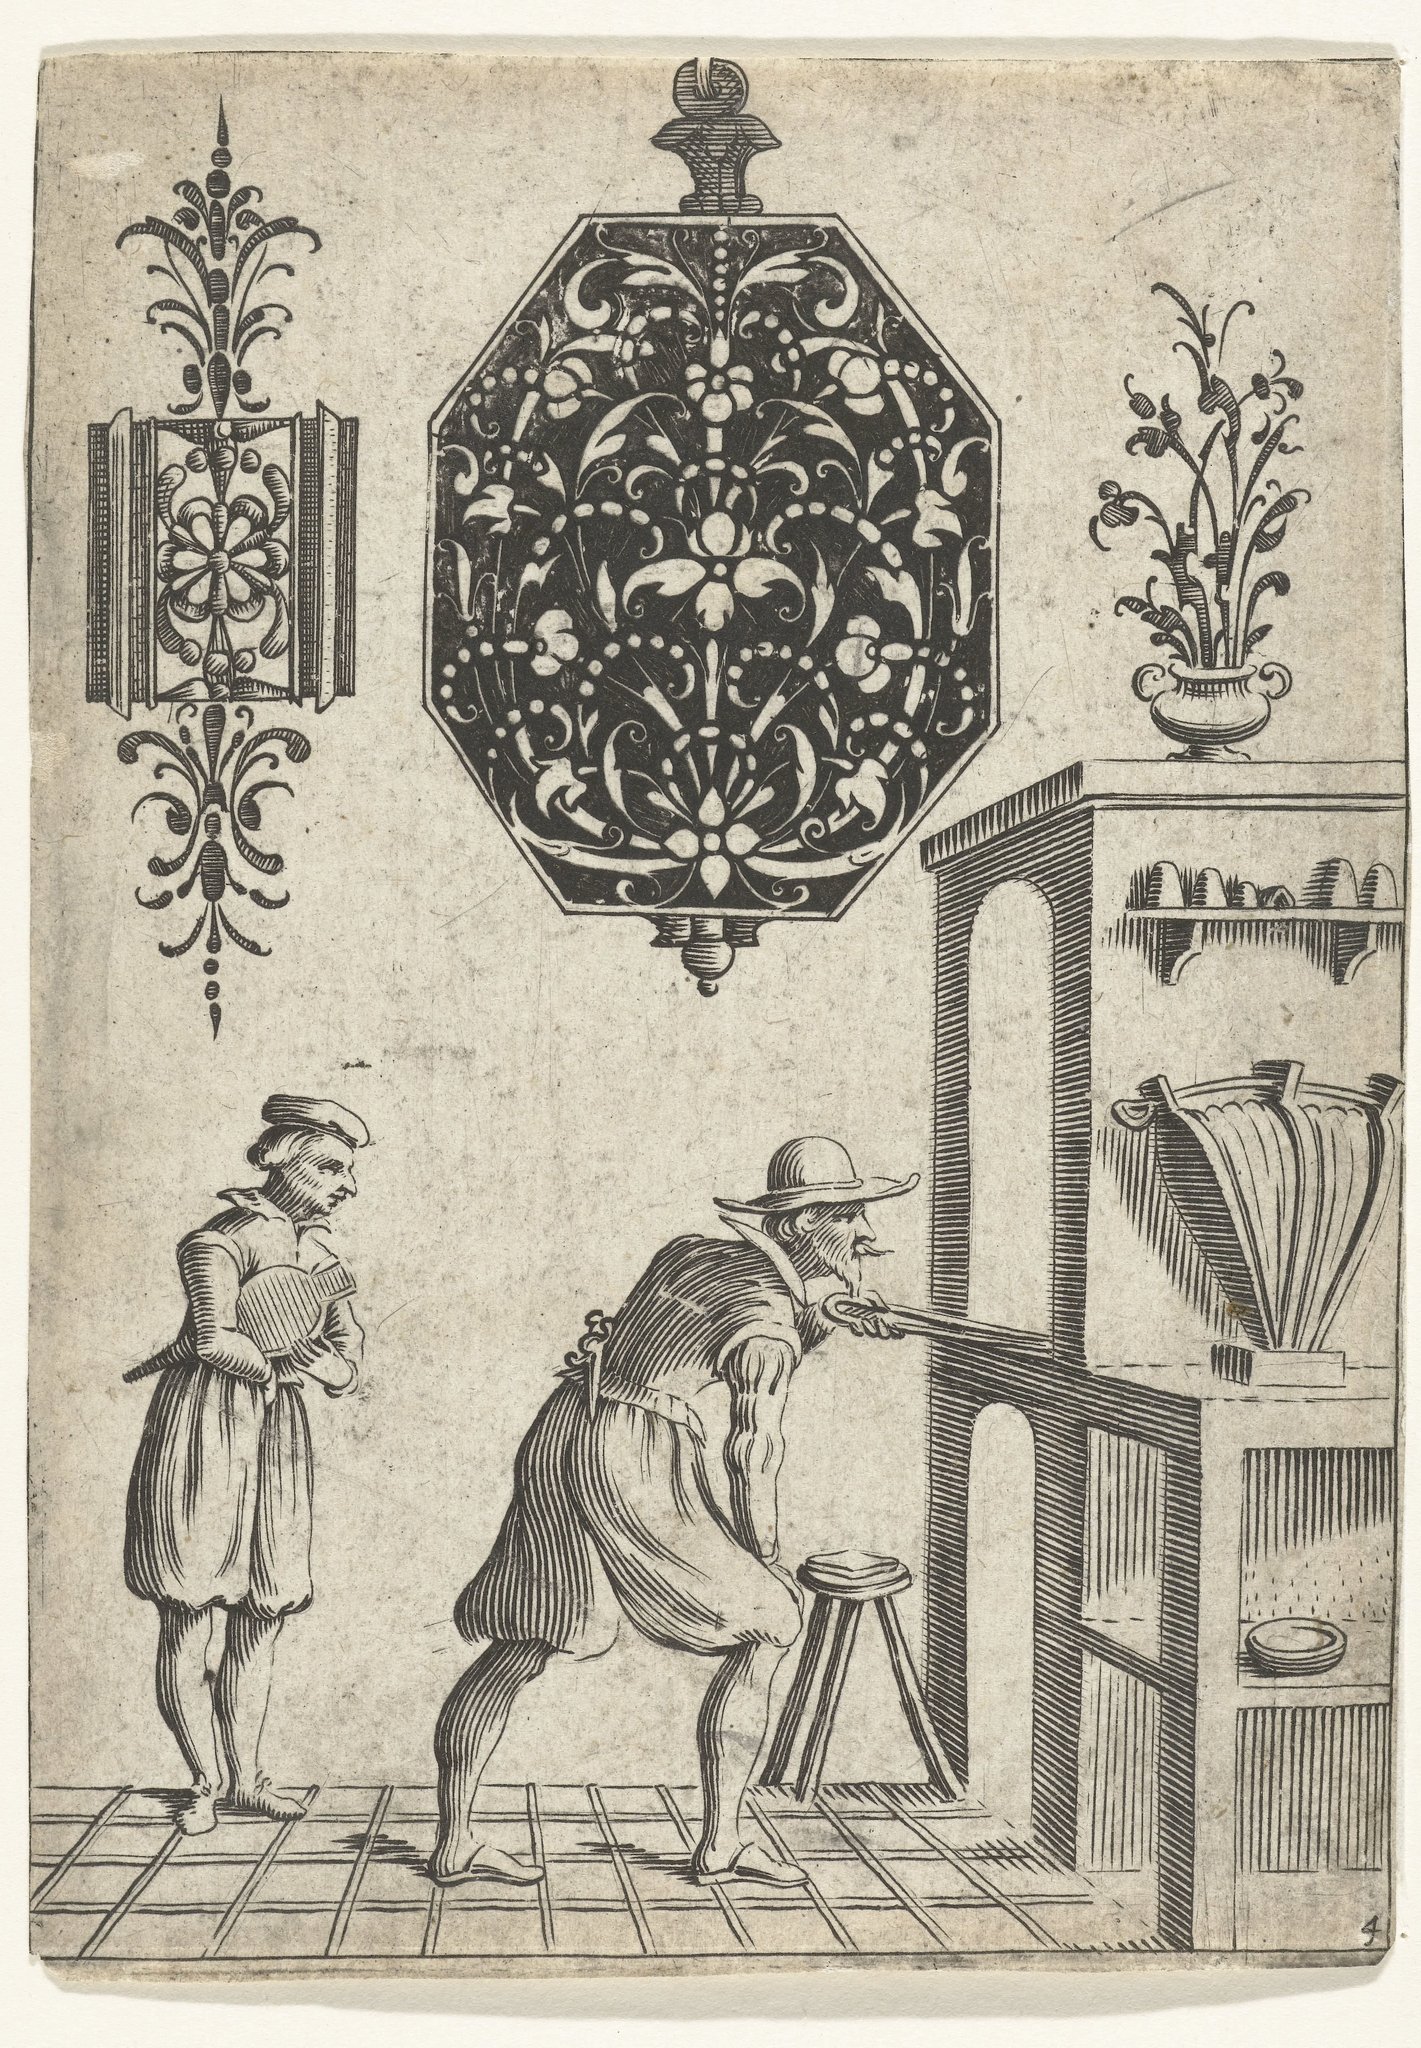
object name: ornament print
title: Twee edelsmidsornamenten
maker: Anonymous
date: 1619-1694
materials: paper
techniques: engraving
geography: châteaudun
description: Onderaan staan een smid en zijn leerling bij een oven.